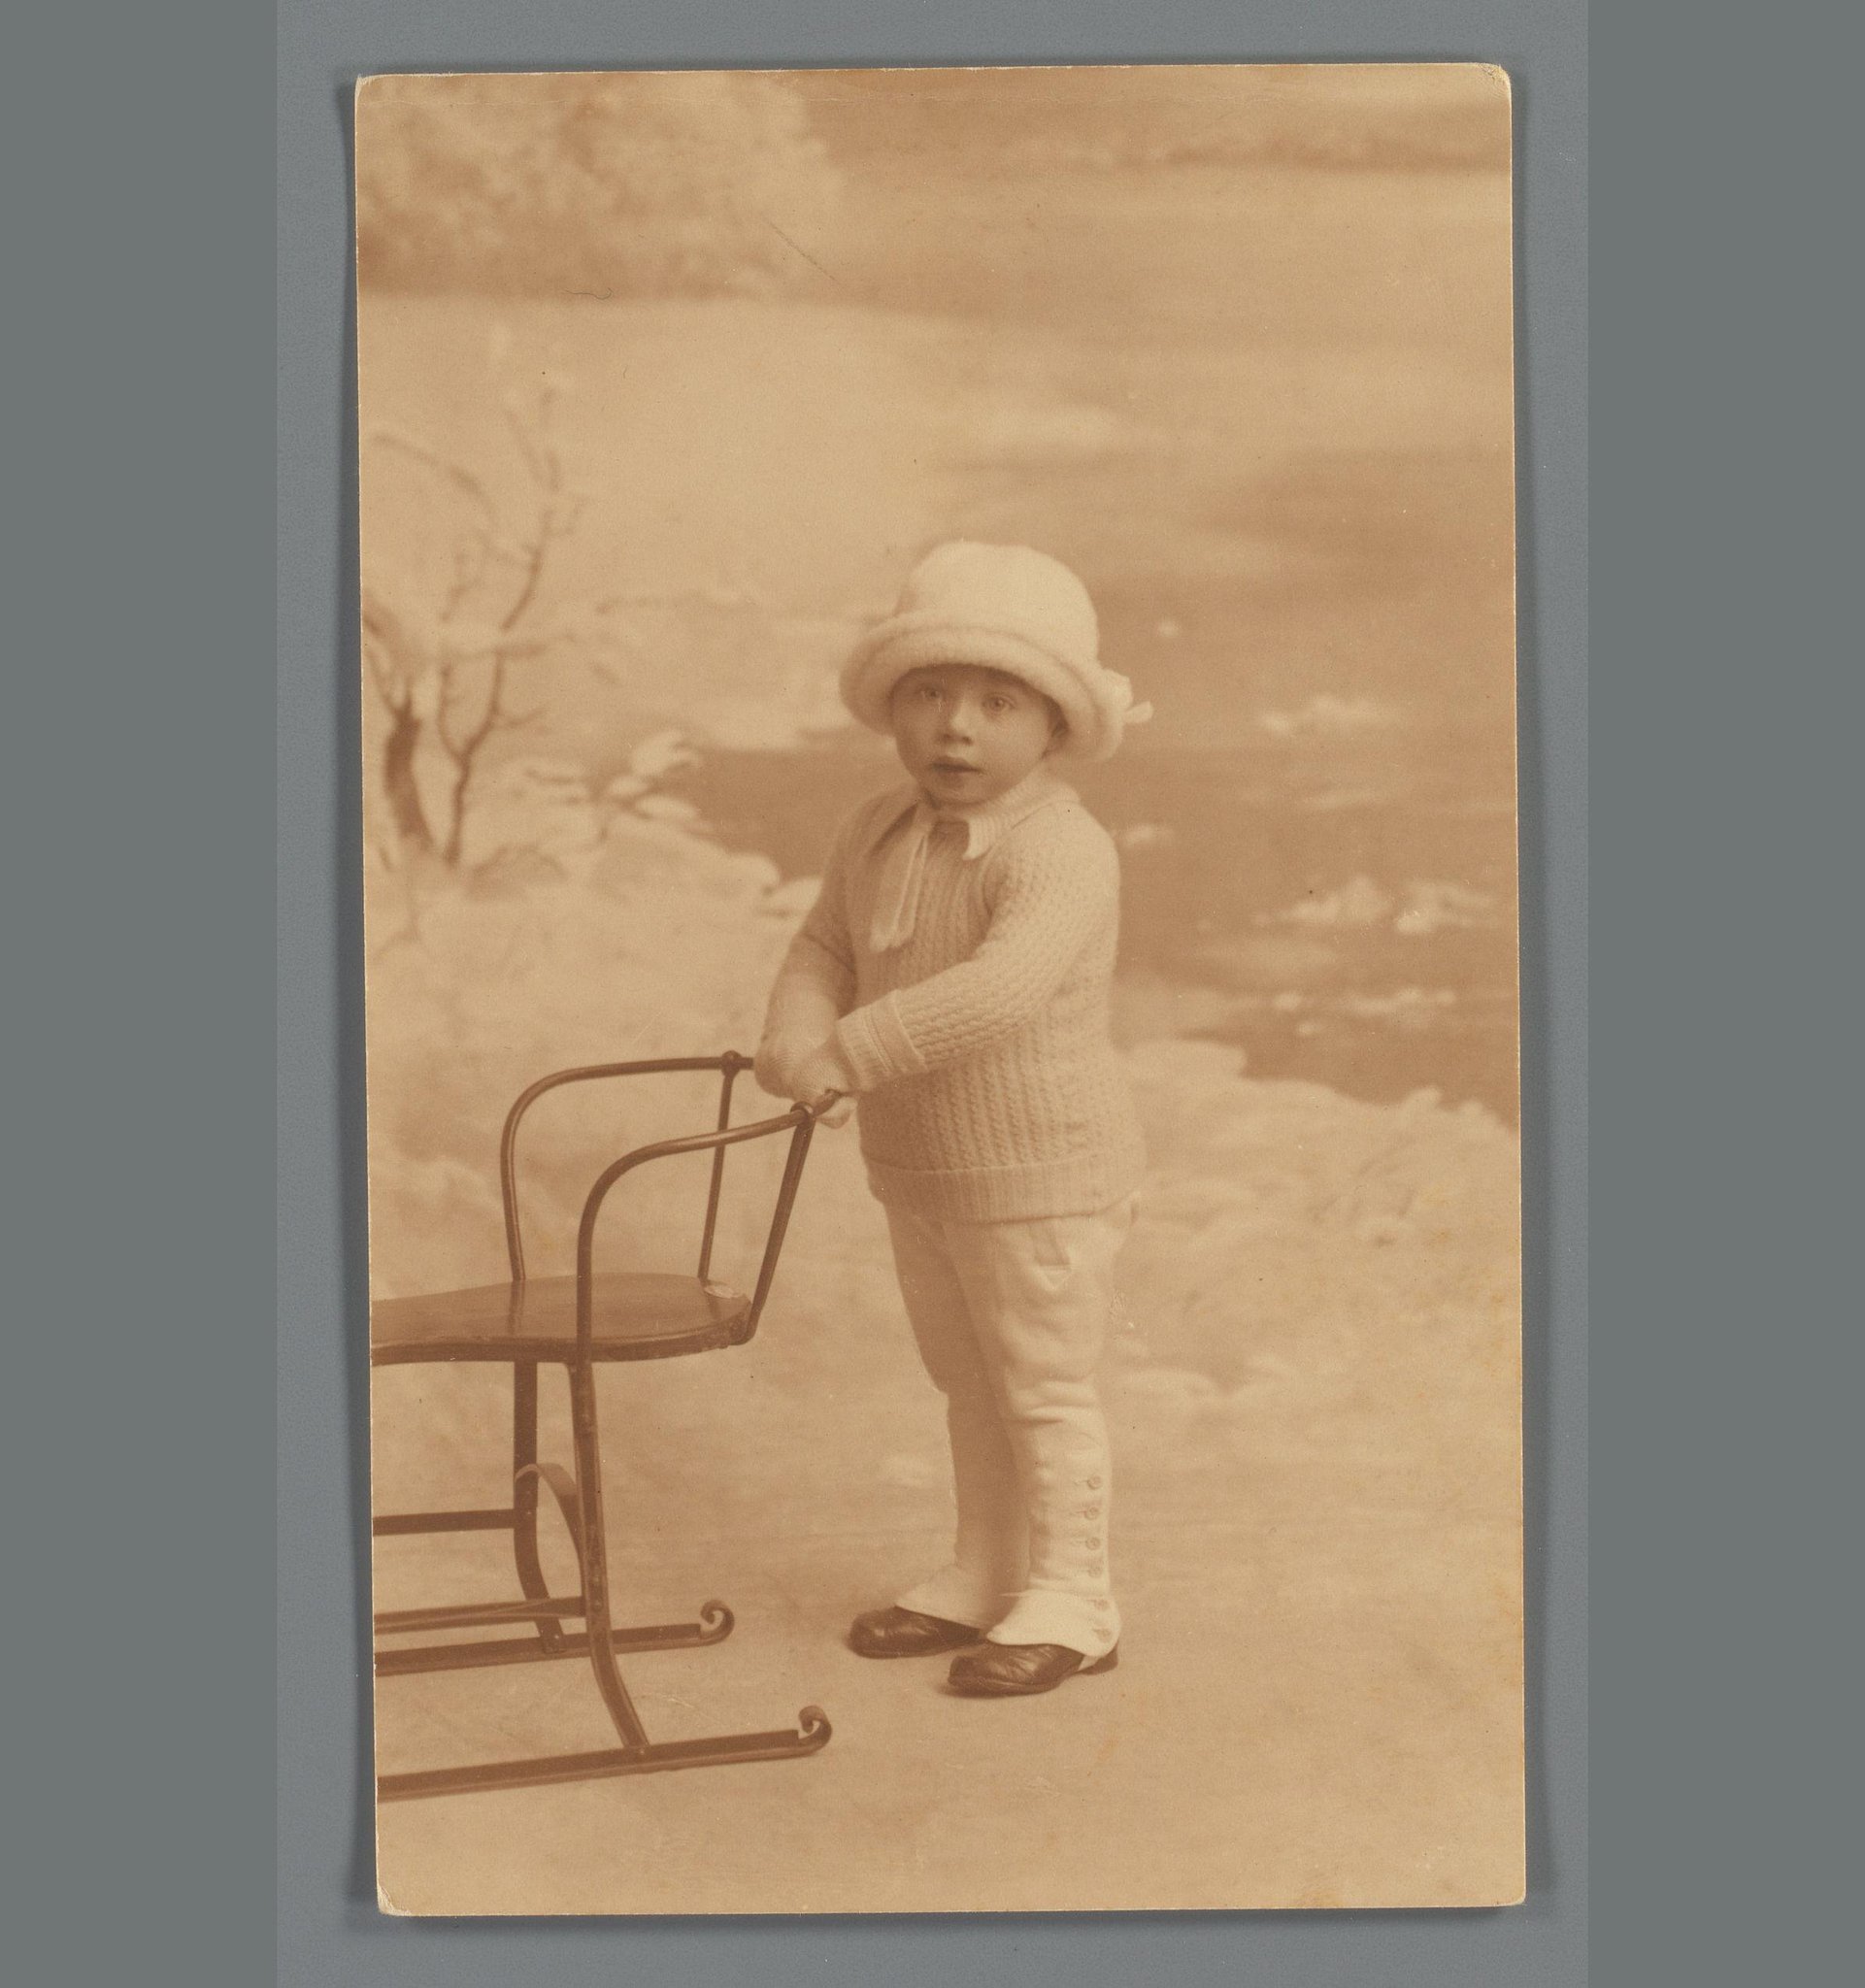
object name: photograph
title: Portret van een onbekend kind in een fotostudio met een winterlandschap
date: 1913-1929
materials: paper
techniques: gelatin silver print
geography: rotterdam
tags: winter landscape; landscape symbolizing winter (the four seasons of the year), historical persons not known by name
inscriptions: inscription: ‘Fotografie Galerij (A. Barnstijn) Stationsweg 37 Rotterdam’, number: ‘2747’